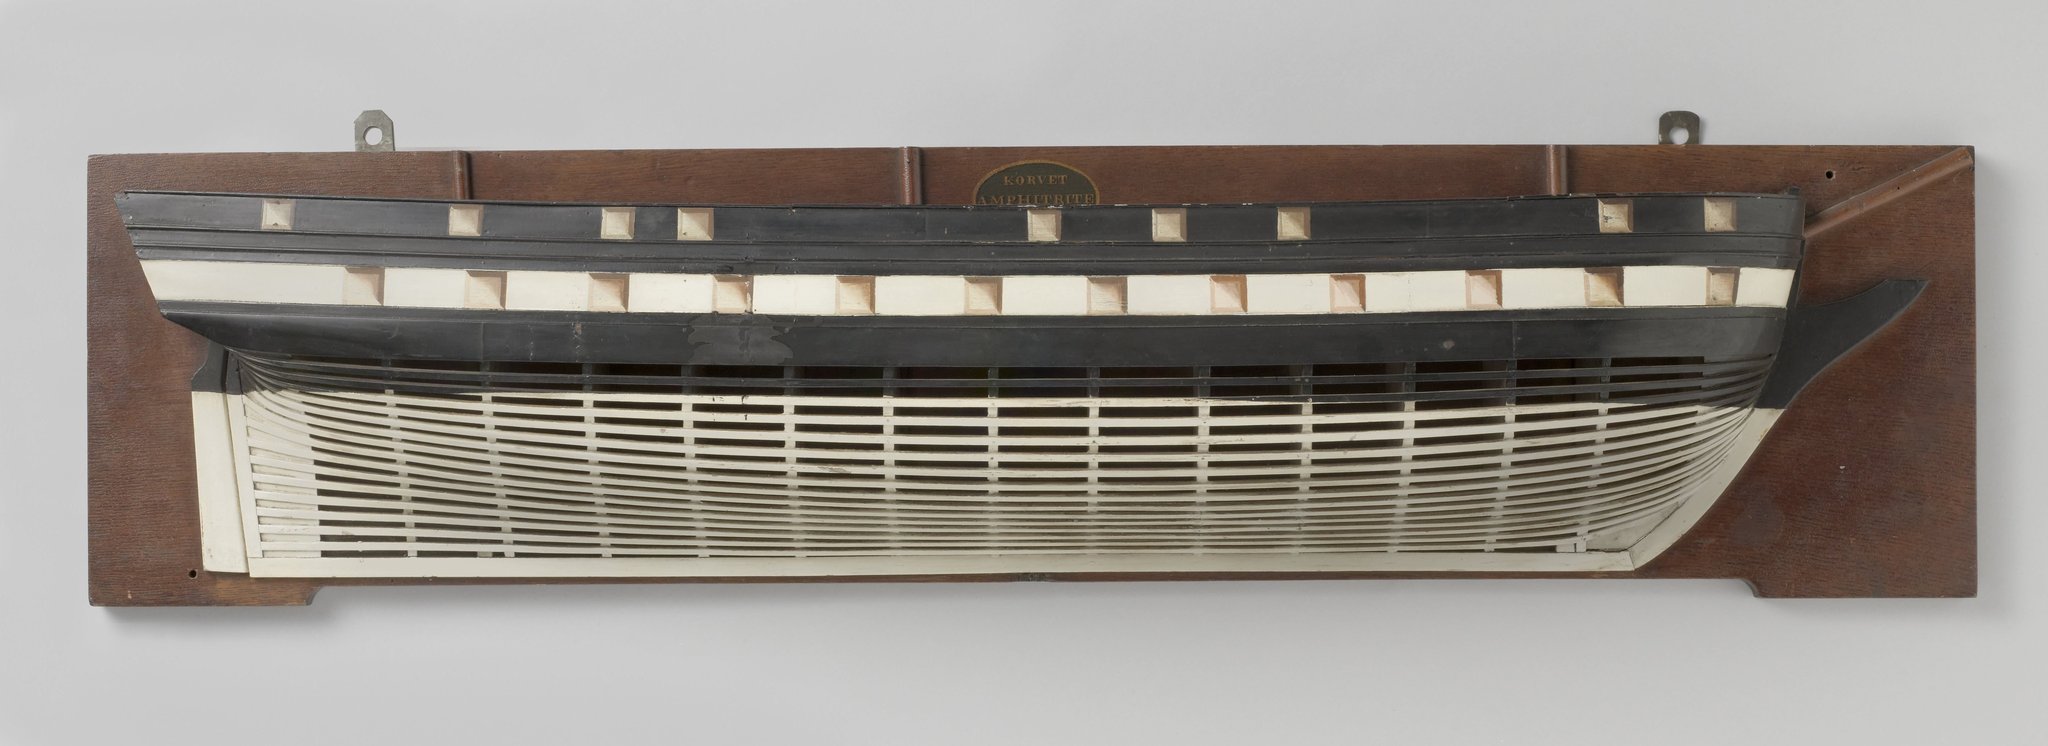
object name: half model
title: Half Model of a Sloop of War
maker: Anonymous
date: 1827-1830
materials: wood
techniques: polychromy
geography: netherlands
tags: amphitrite (schip)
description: De korvet van 32 stukken Amphitrite, lang 39 meter, werd in 1827-1830 door Cornelis Soetermeer te Vlissingen gebouwd. In 1836 werd het geraseerd tot gladdekskorvet van 20 stukken. Het schip werd in 1851 in Curaçao afgevoerd en het jaar daarop gesloopt.